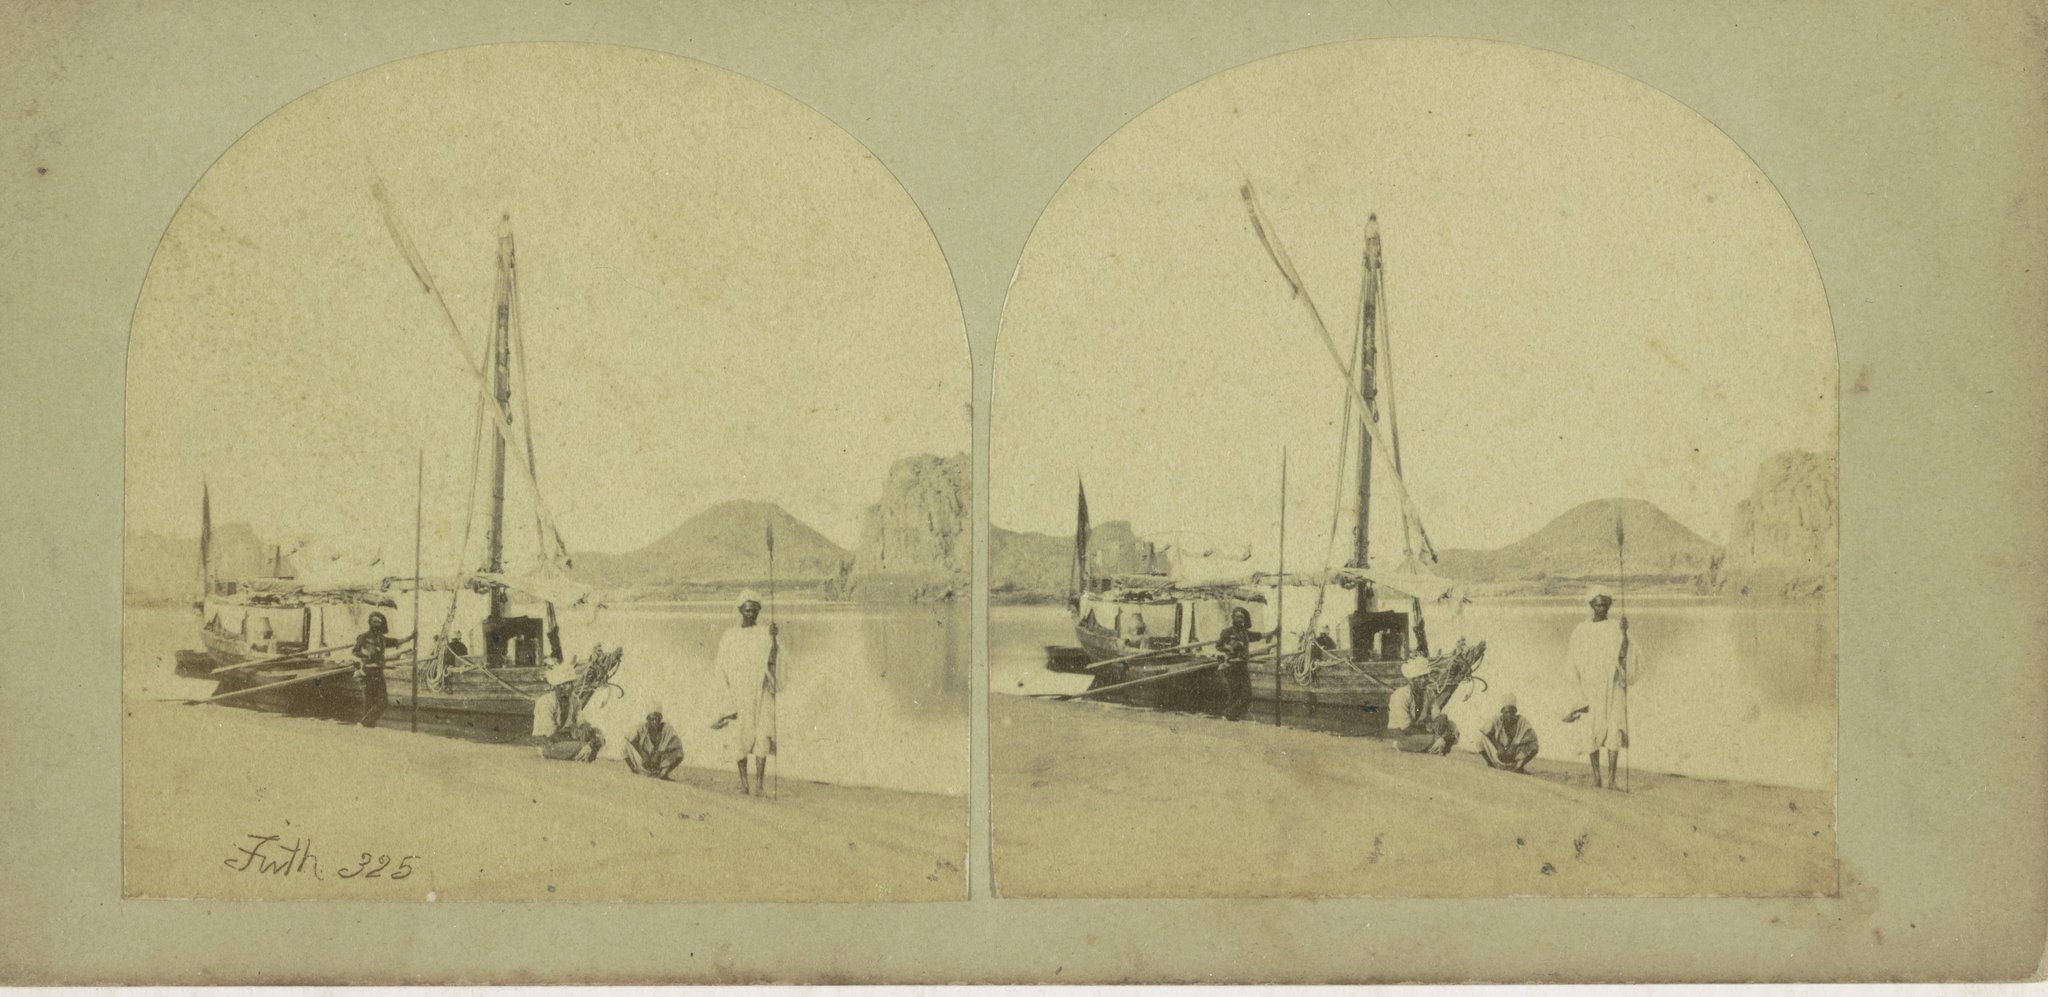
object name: stereograph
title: Nubische Egyptenaren aan de oever van de Nijl naast een Dahabieh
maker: francis frith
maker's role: publisher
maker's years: 1822-1898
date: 1857-1859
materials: cardboard, paper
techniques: albumen print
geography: egypt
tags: african peoples, africans (nubians), ships (in general)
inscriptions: inscription: ‘About from 100 to 150 of these boats are hired annually, by European and American (...)’, number: ‘325’, inscription: ‘[Deposé.’, inscription: ‘1e Negretti en Zambra uitgever film Frith (1857-58)’, inscription: ‘Entered at Stationers' Hall.]’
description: Egyptenaren beschreven als Nubisch naar aanleiding van de titel op het object.